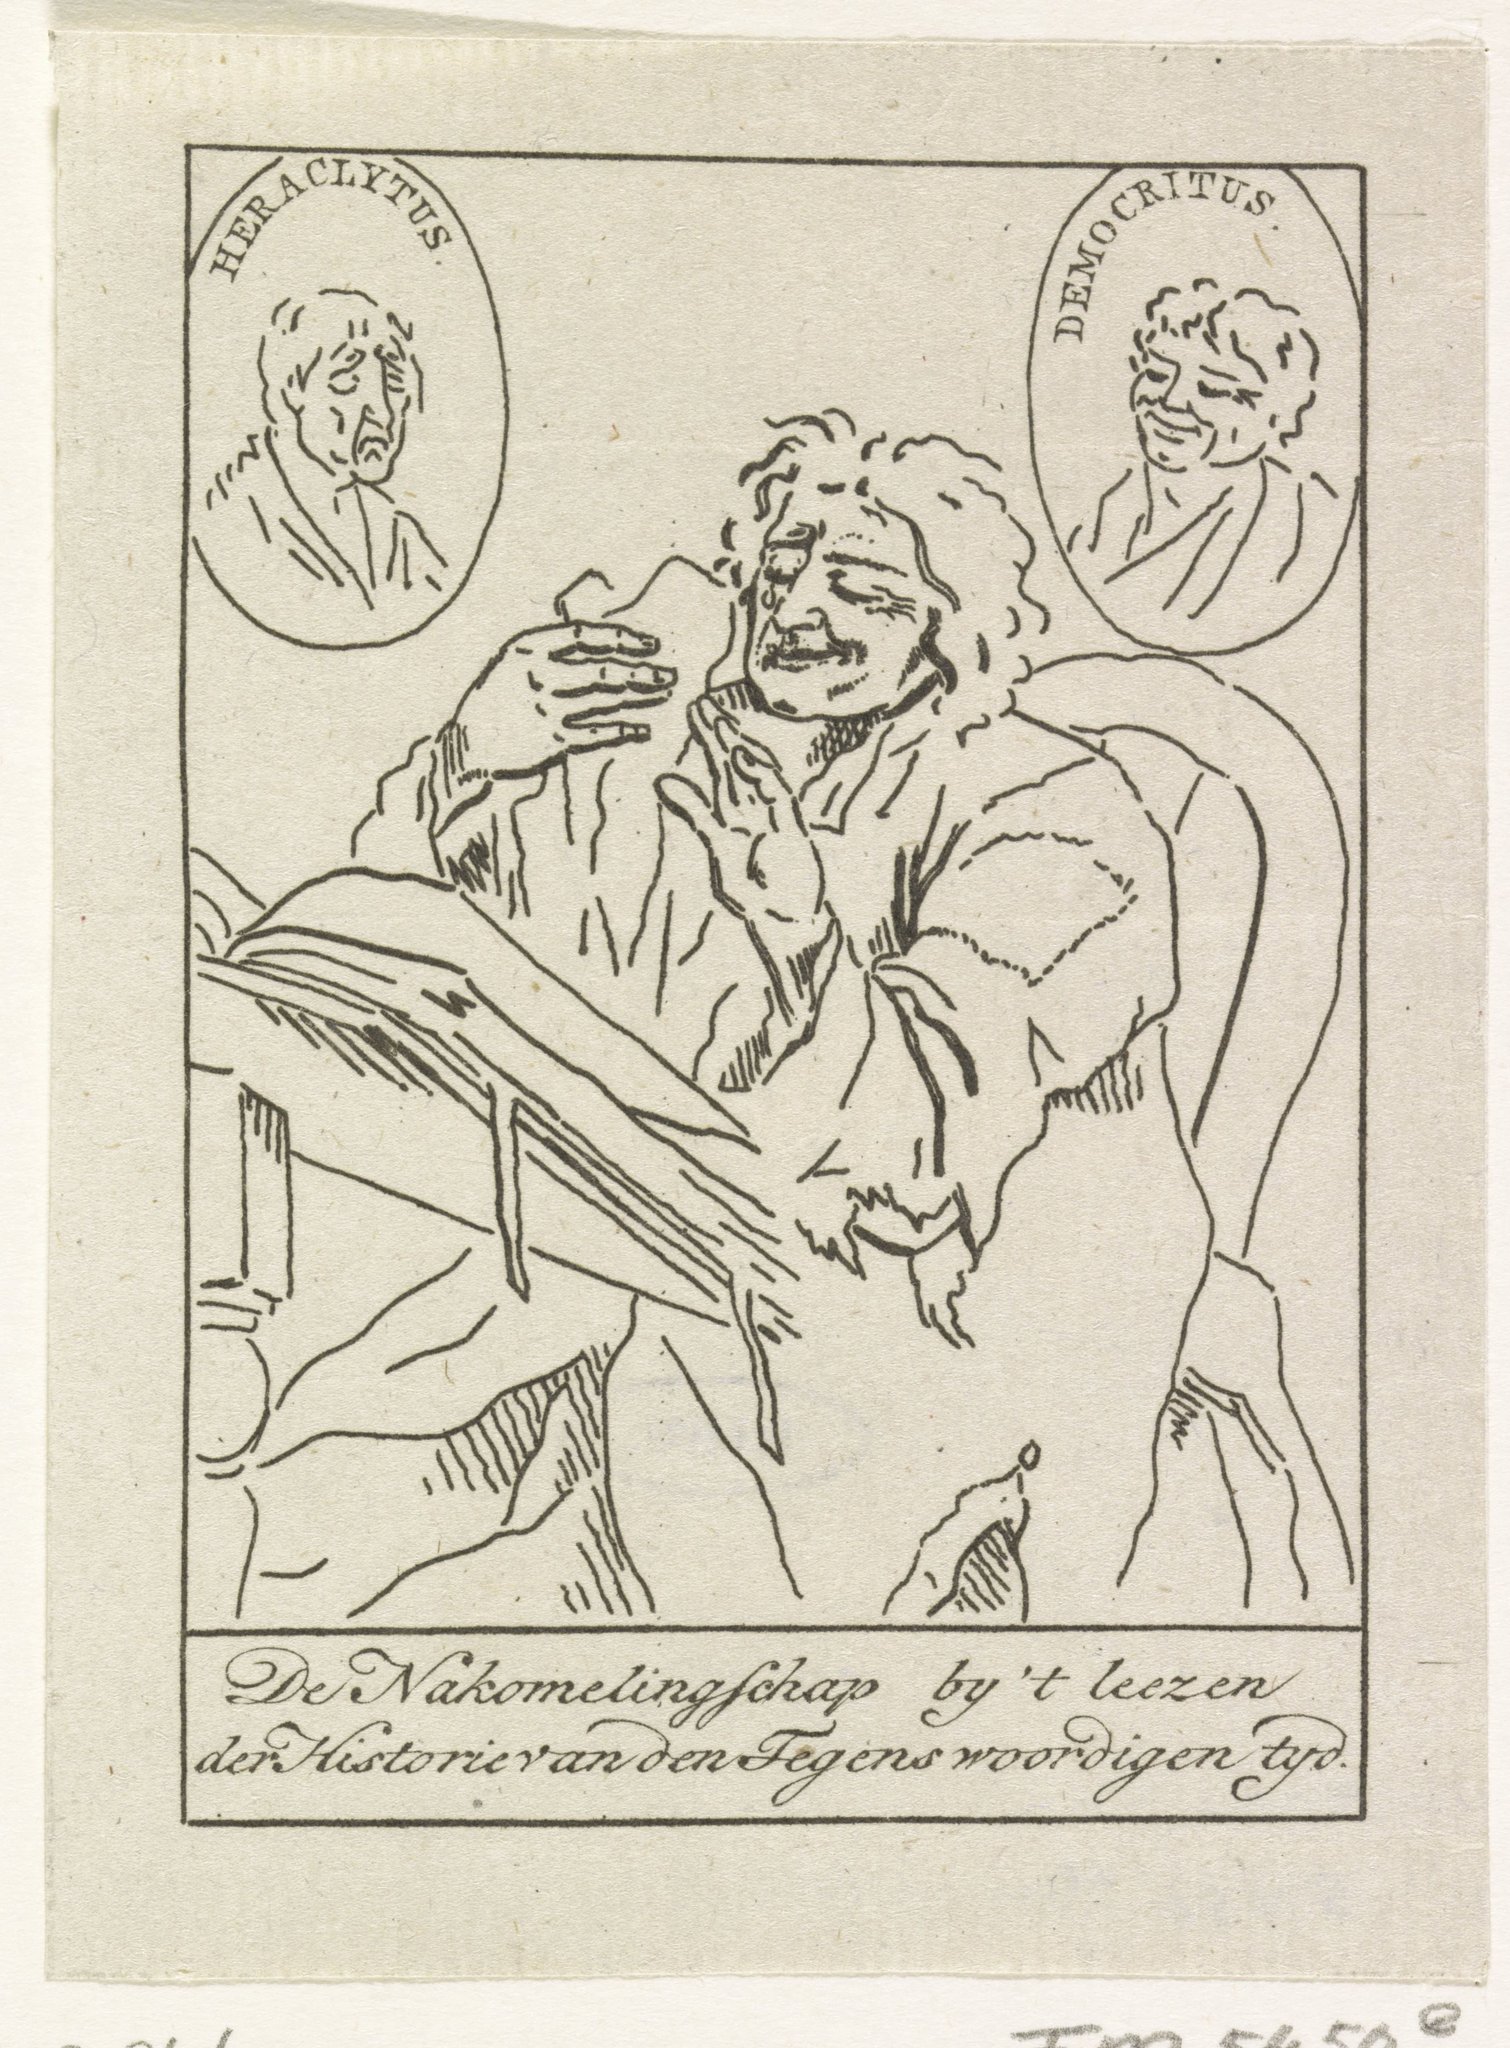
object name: cartoon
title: Nakomeling lezend over de historie van de tegenwoordige tijd, 1796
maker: pieter van woensel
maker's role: print maker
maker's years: 1747-1808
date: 1795-1796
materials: paper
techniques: etching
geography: netherlands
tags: reading, heraclitus, the weeping philosopher, and democritus, the laughing philosopher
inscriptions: collector's mark: Lugt 2228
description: Spotprent van een man (onze nakomeling) die bij het lezen van de historie van de tegenwoordige tijd zowel moet huilen als lachen, 1796. Bovenaan twee medaillons met Heraclitus en Democritus.